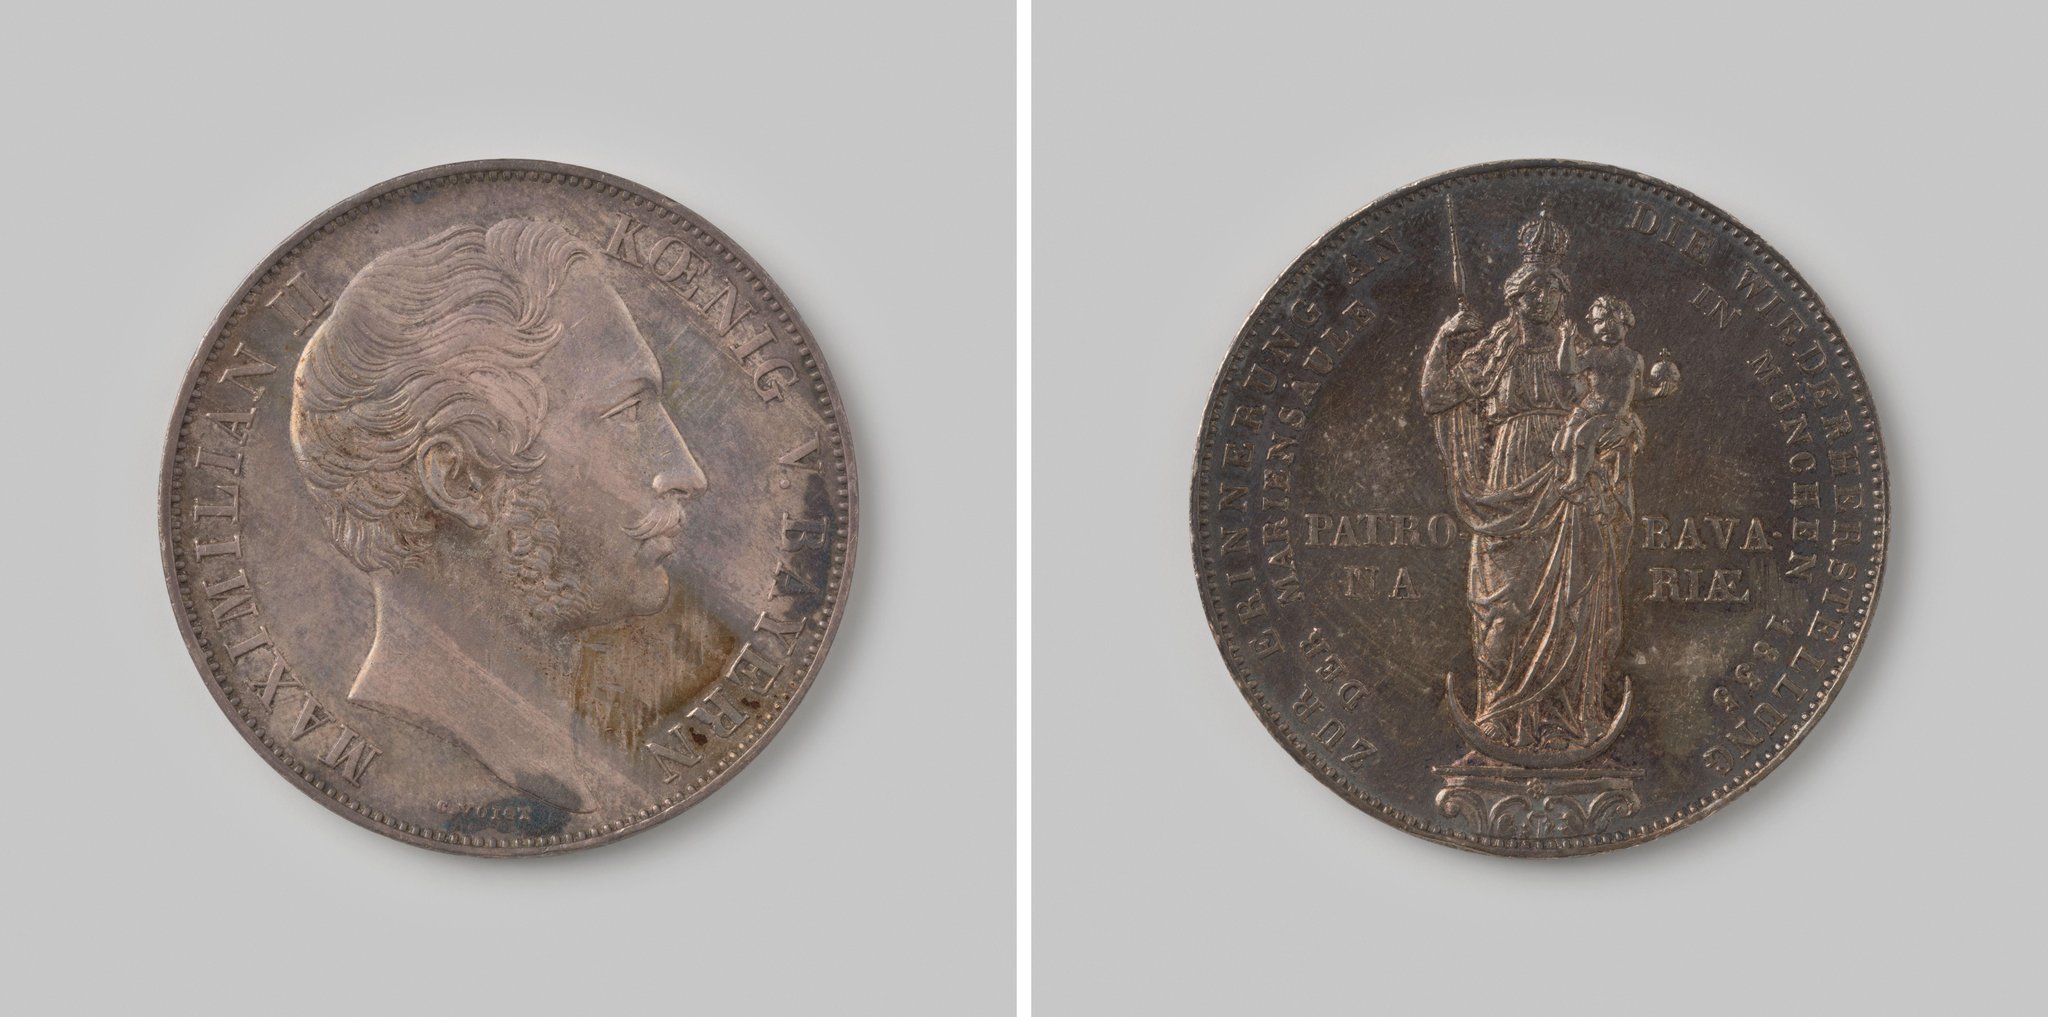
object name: coin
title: Koninkrijk Beieren, gedenkdoppelgulden, Maximilian II, 1855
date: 1855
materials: silver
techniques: striking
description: Zilveren munt. Voorzijde: borstbeeld van de koning naar rechts. Keerzijde: standbeeld van de op een maansikkel staande Madonna met kind met zwaard en rijksappel. Dubbel omschrift, waarin jaartal. Randschrift.